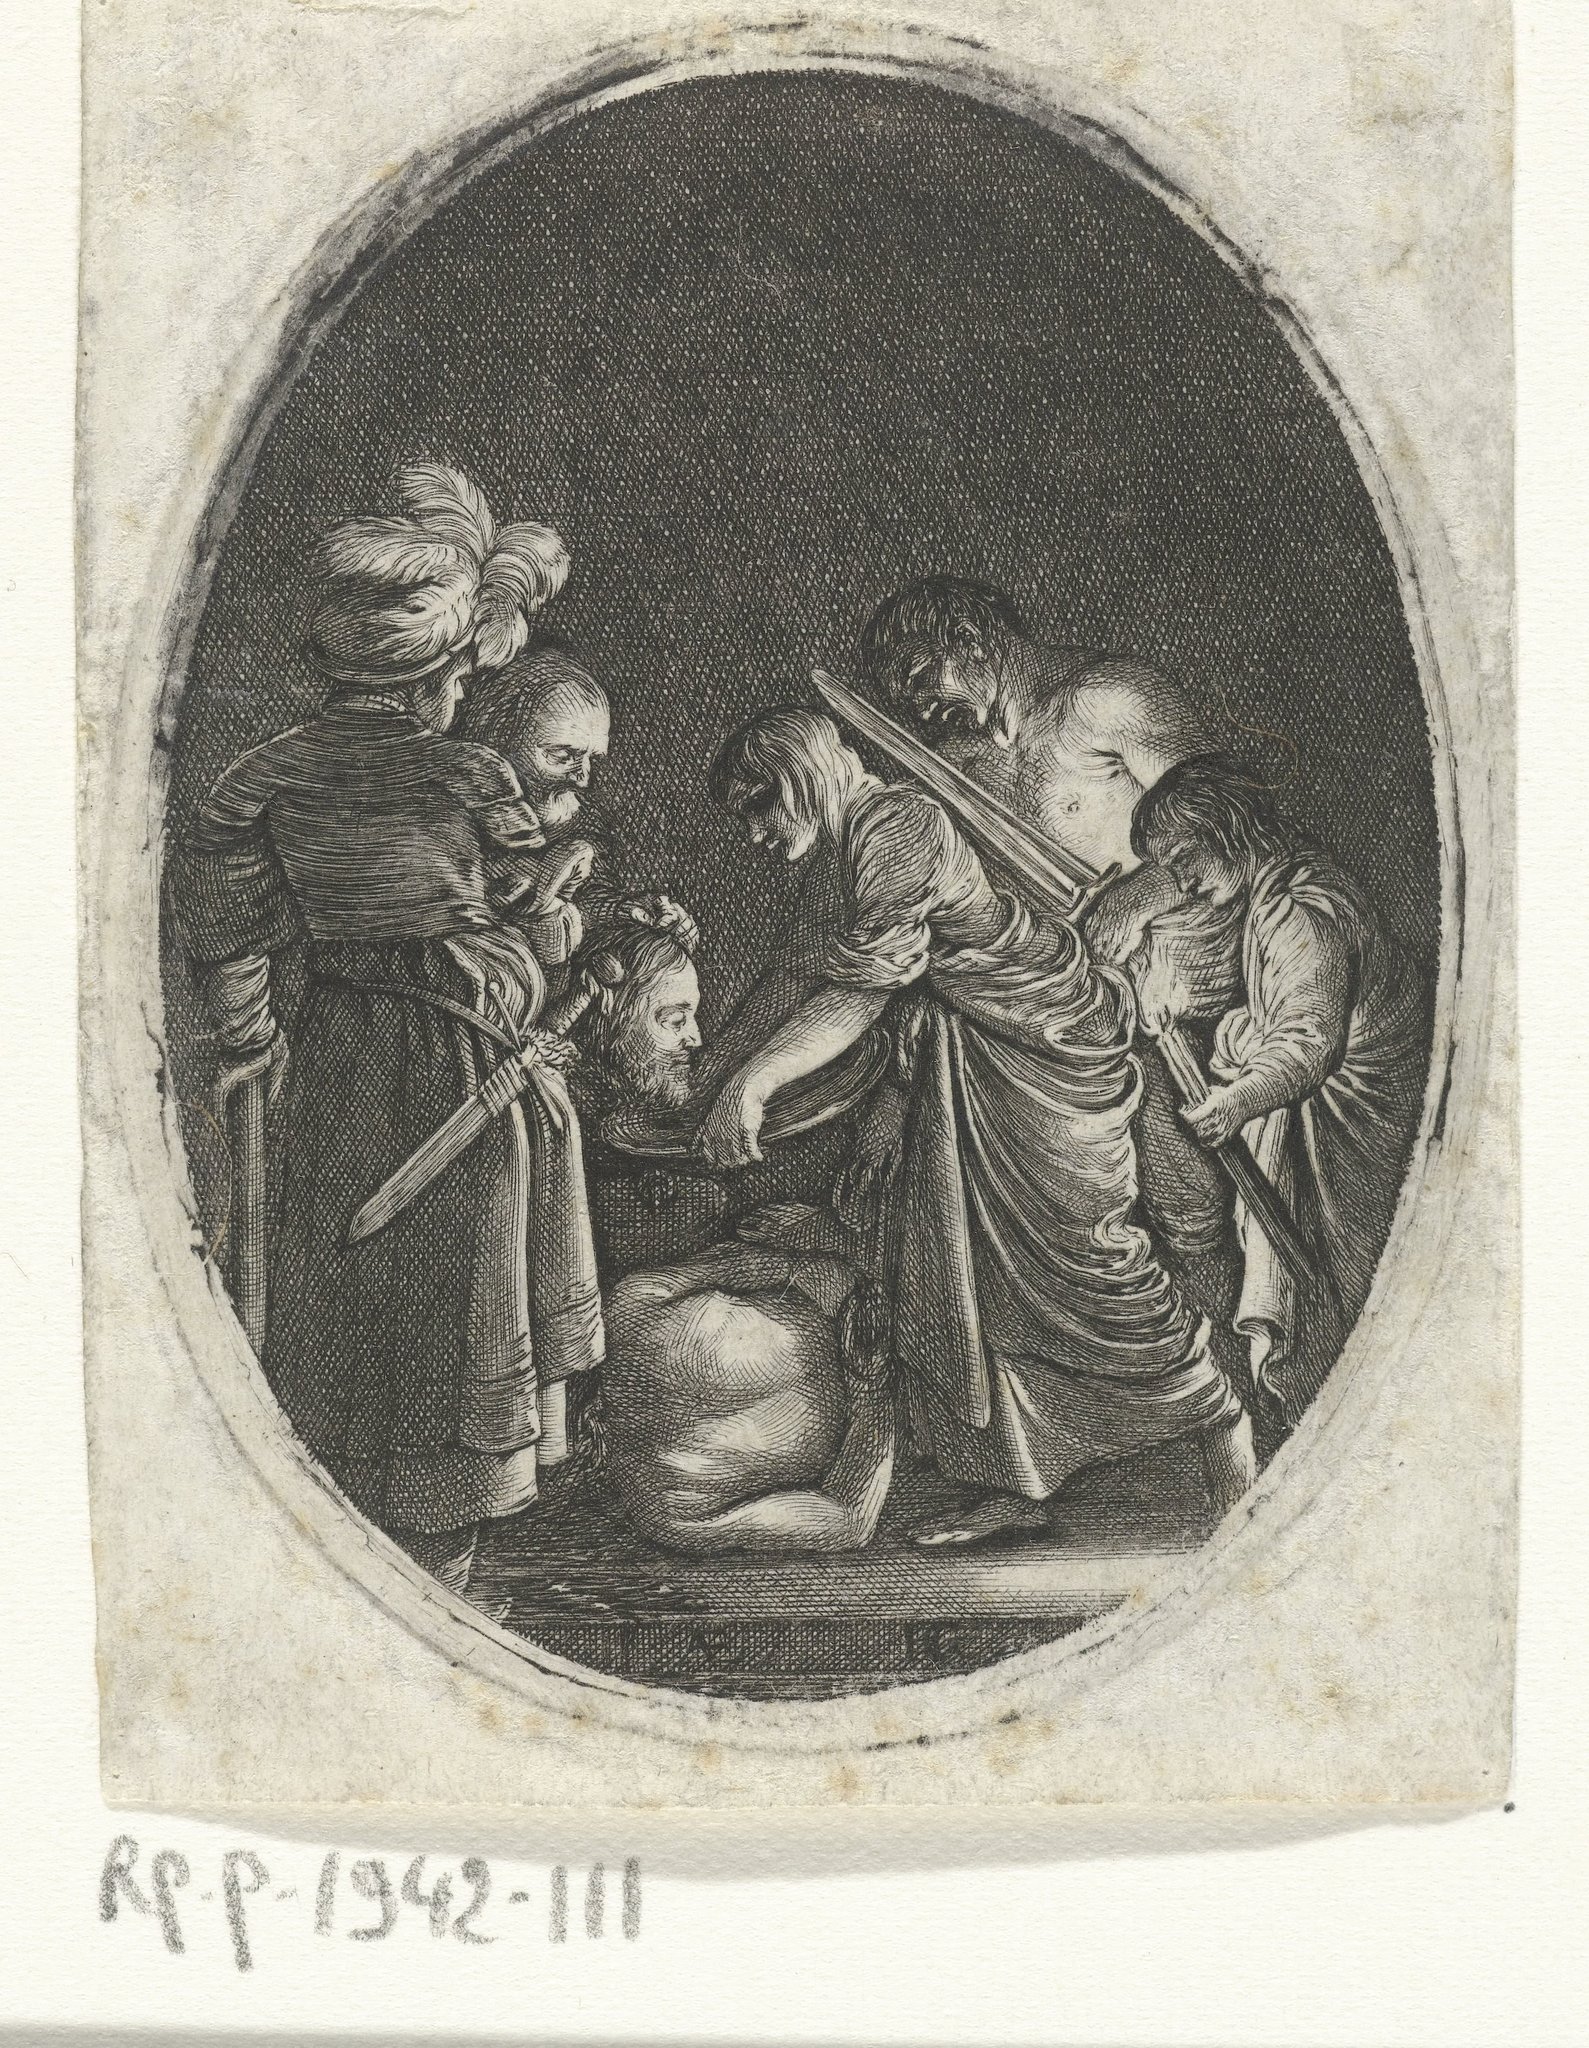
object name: print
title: Presentatie van het hoofd van Johannes de Doper aan Salome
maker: hendrick goudt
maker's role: draughtsman, print maker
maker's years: 1581-1648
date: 1591-1648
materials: paper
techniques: engraving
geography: rome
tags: salome is given the head of john the baptist by the executioner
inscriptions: collector's mark: Lugt 2228, collector's mark: Lugt 2760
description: In een ovale lijst: de beul presenteert het hoofd van Johannes de Doper aan Salome, die een schotel vasthoudt. Naar een schilderij van Adam Elsheimer.